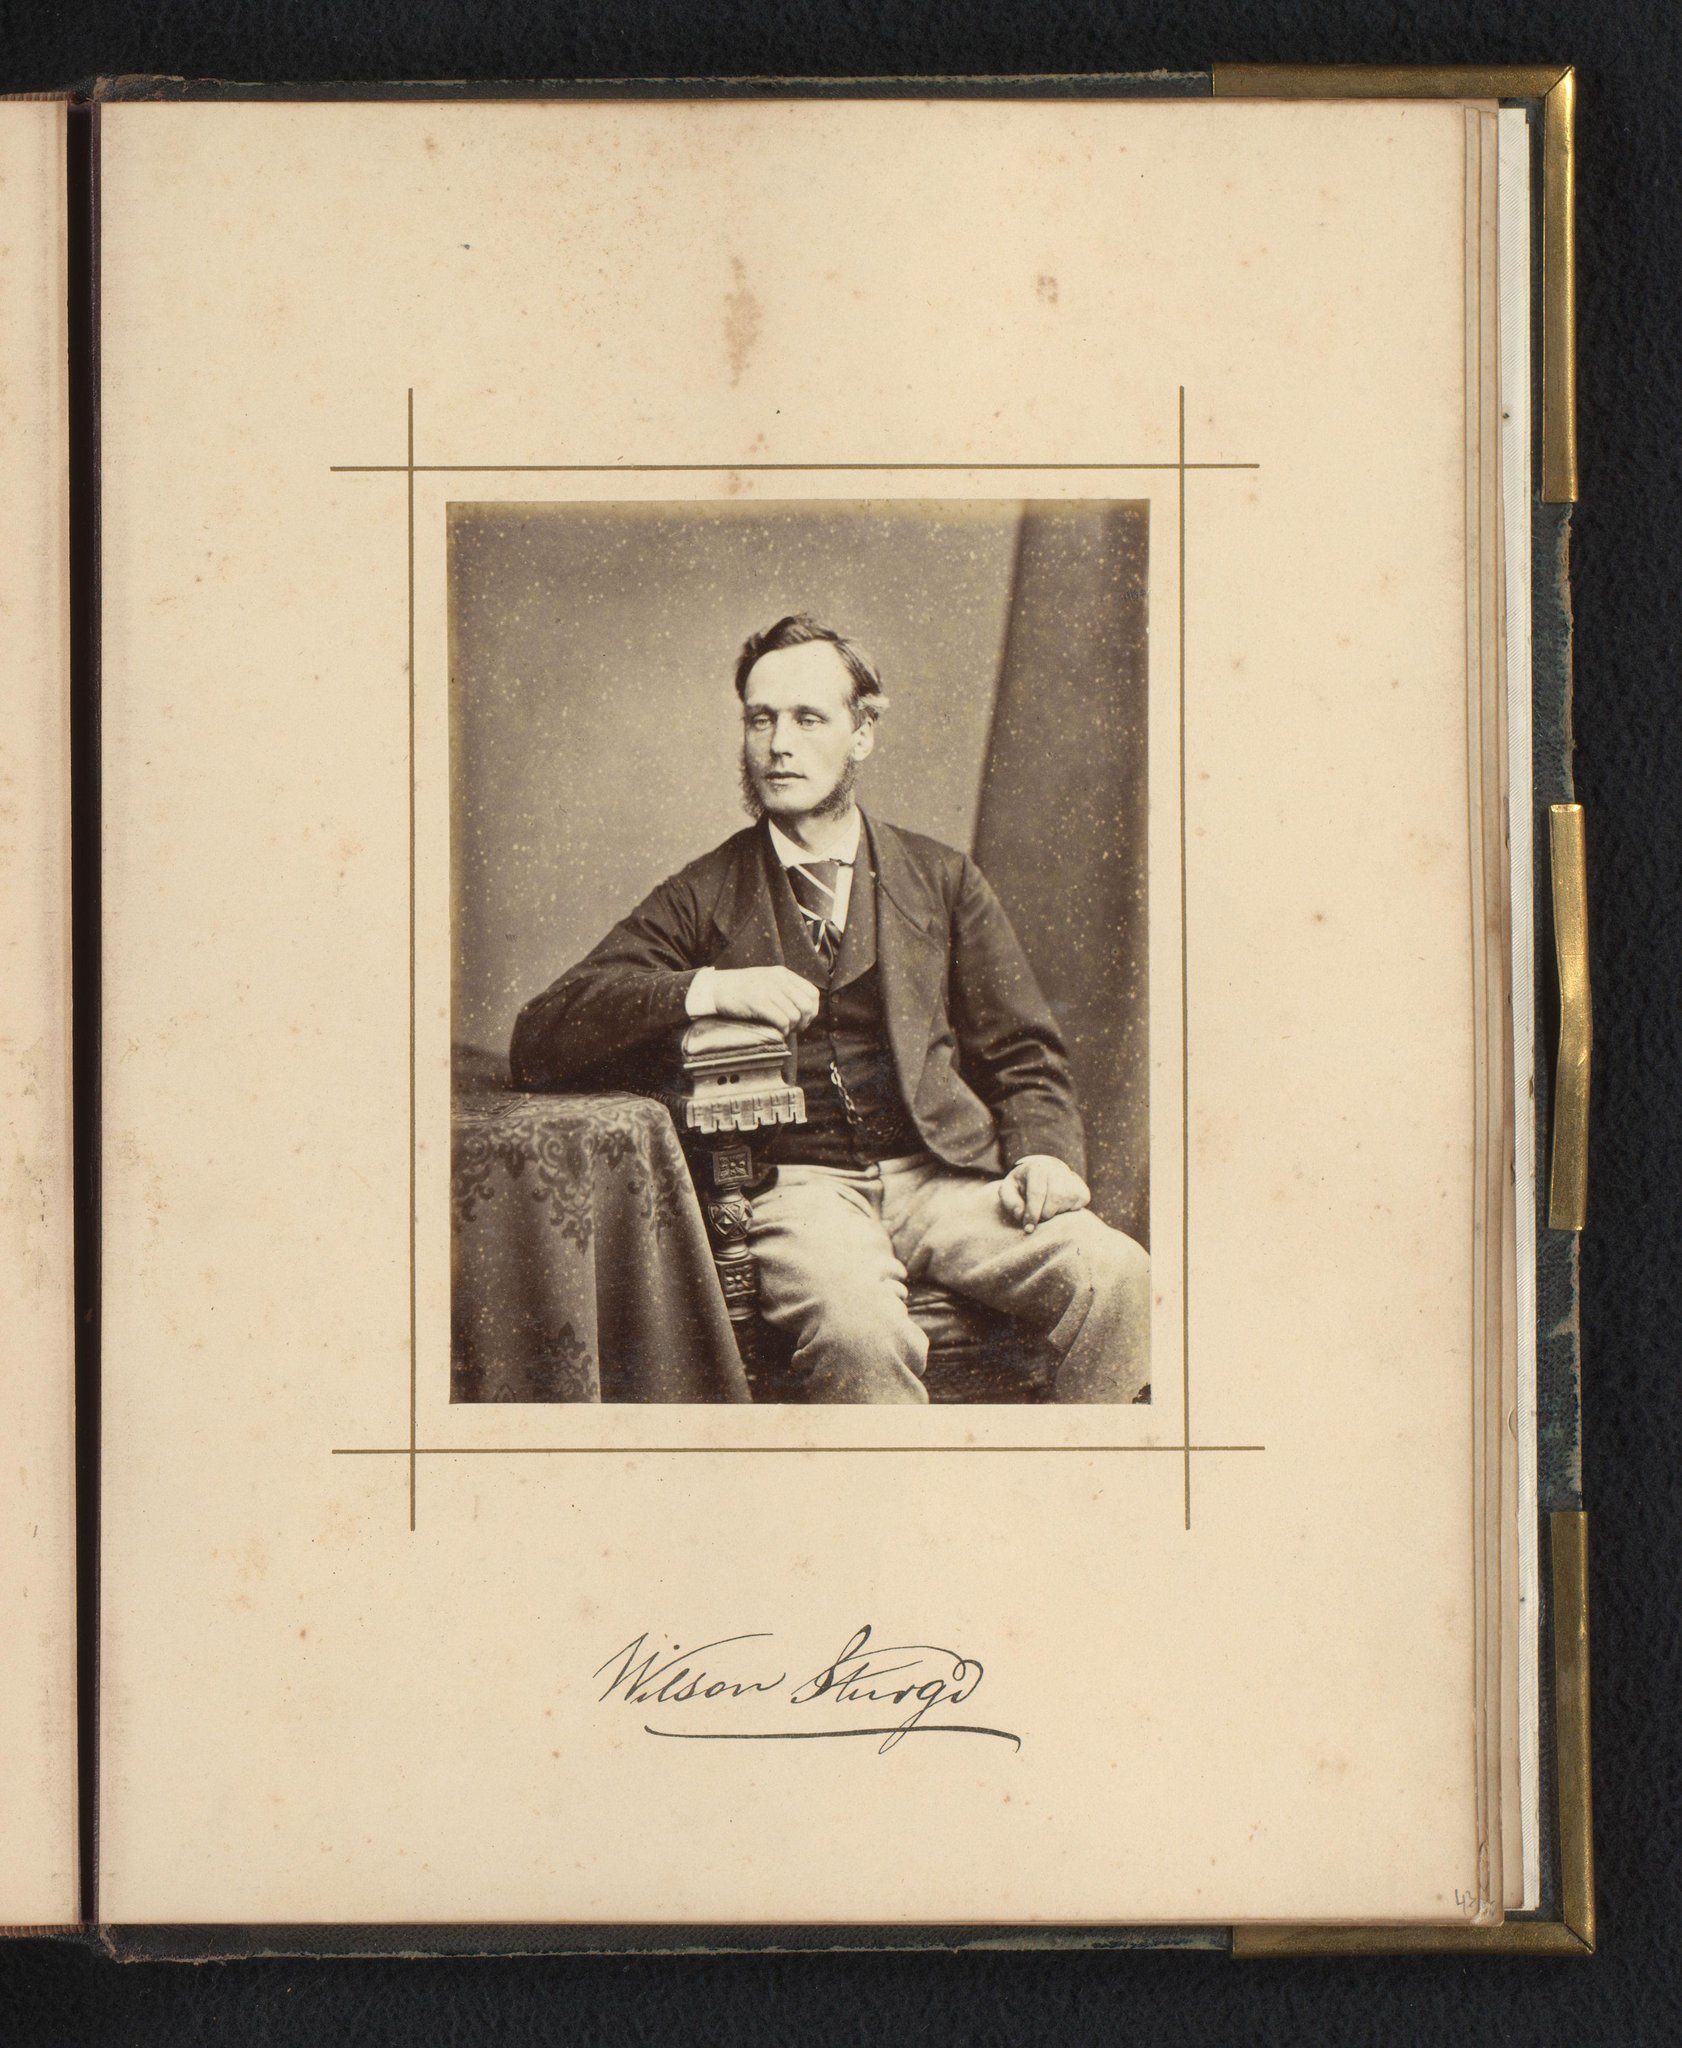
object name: photograph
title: Portret van Wilson Sturge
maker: Anonymous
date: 1866-1871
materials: photographic support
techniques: albumen print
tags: sitting figure, historical persons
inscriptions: name: ‘Wilson Sturge’